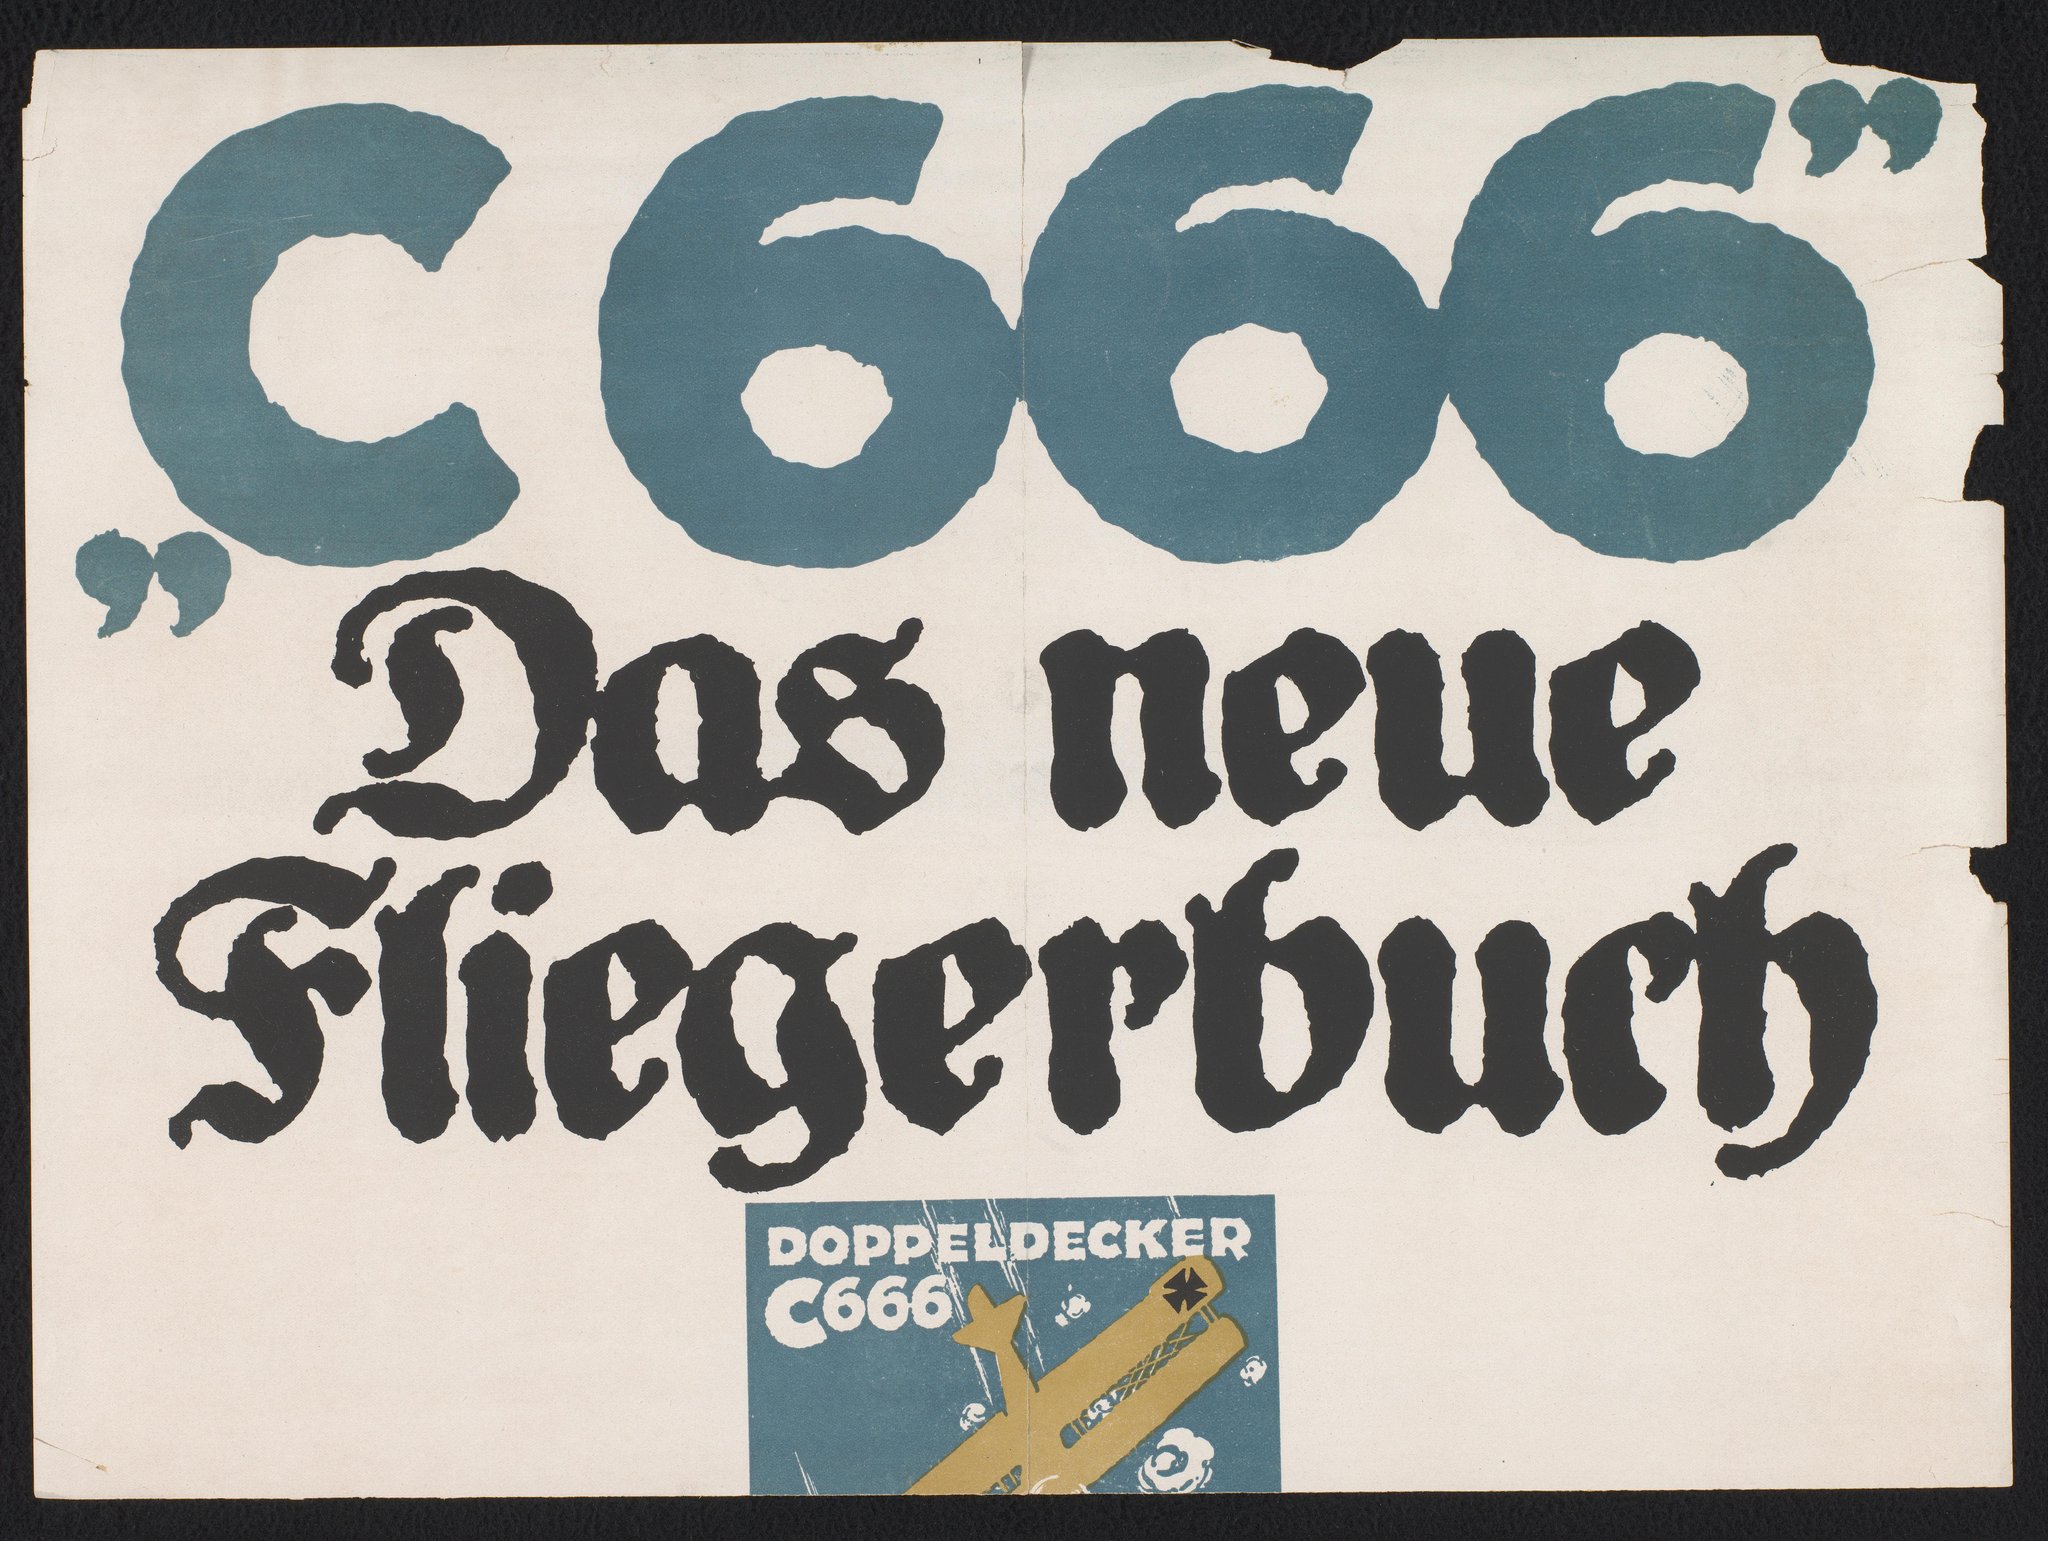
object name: print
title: 'C666' das neue Fliegerbuch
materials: paper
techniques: lithograph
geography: berlin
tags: aircraft, aeroplane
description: Bovenste helft van een affiche ter promotie van de publicatie van een boek over een Duits dubbeldekker vliegtuig uit de Eerste Wereldoorlog.